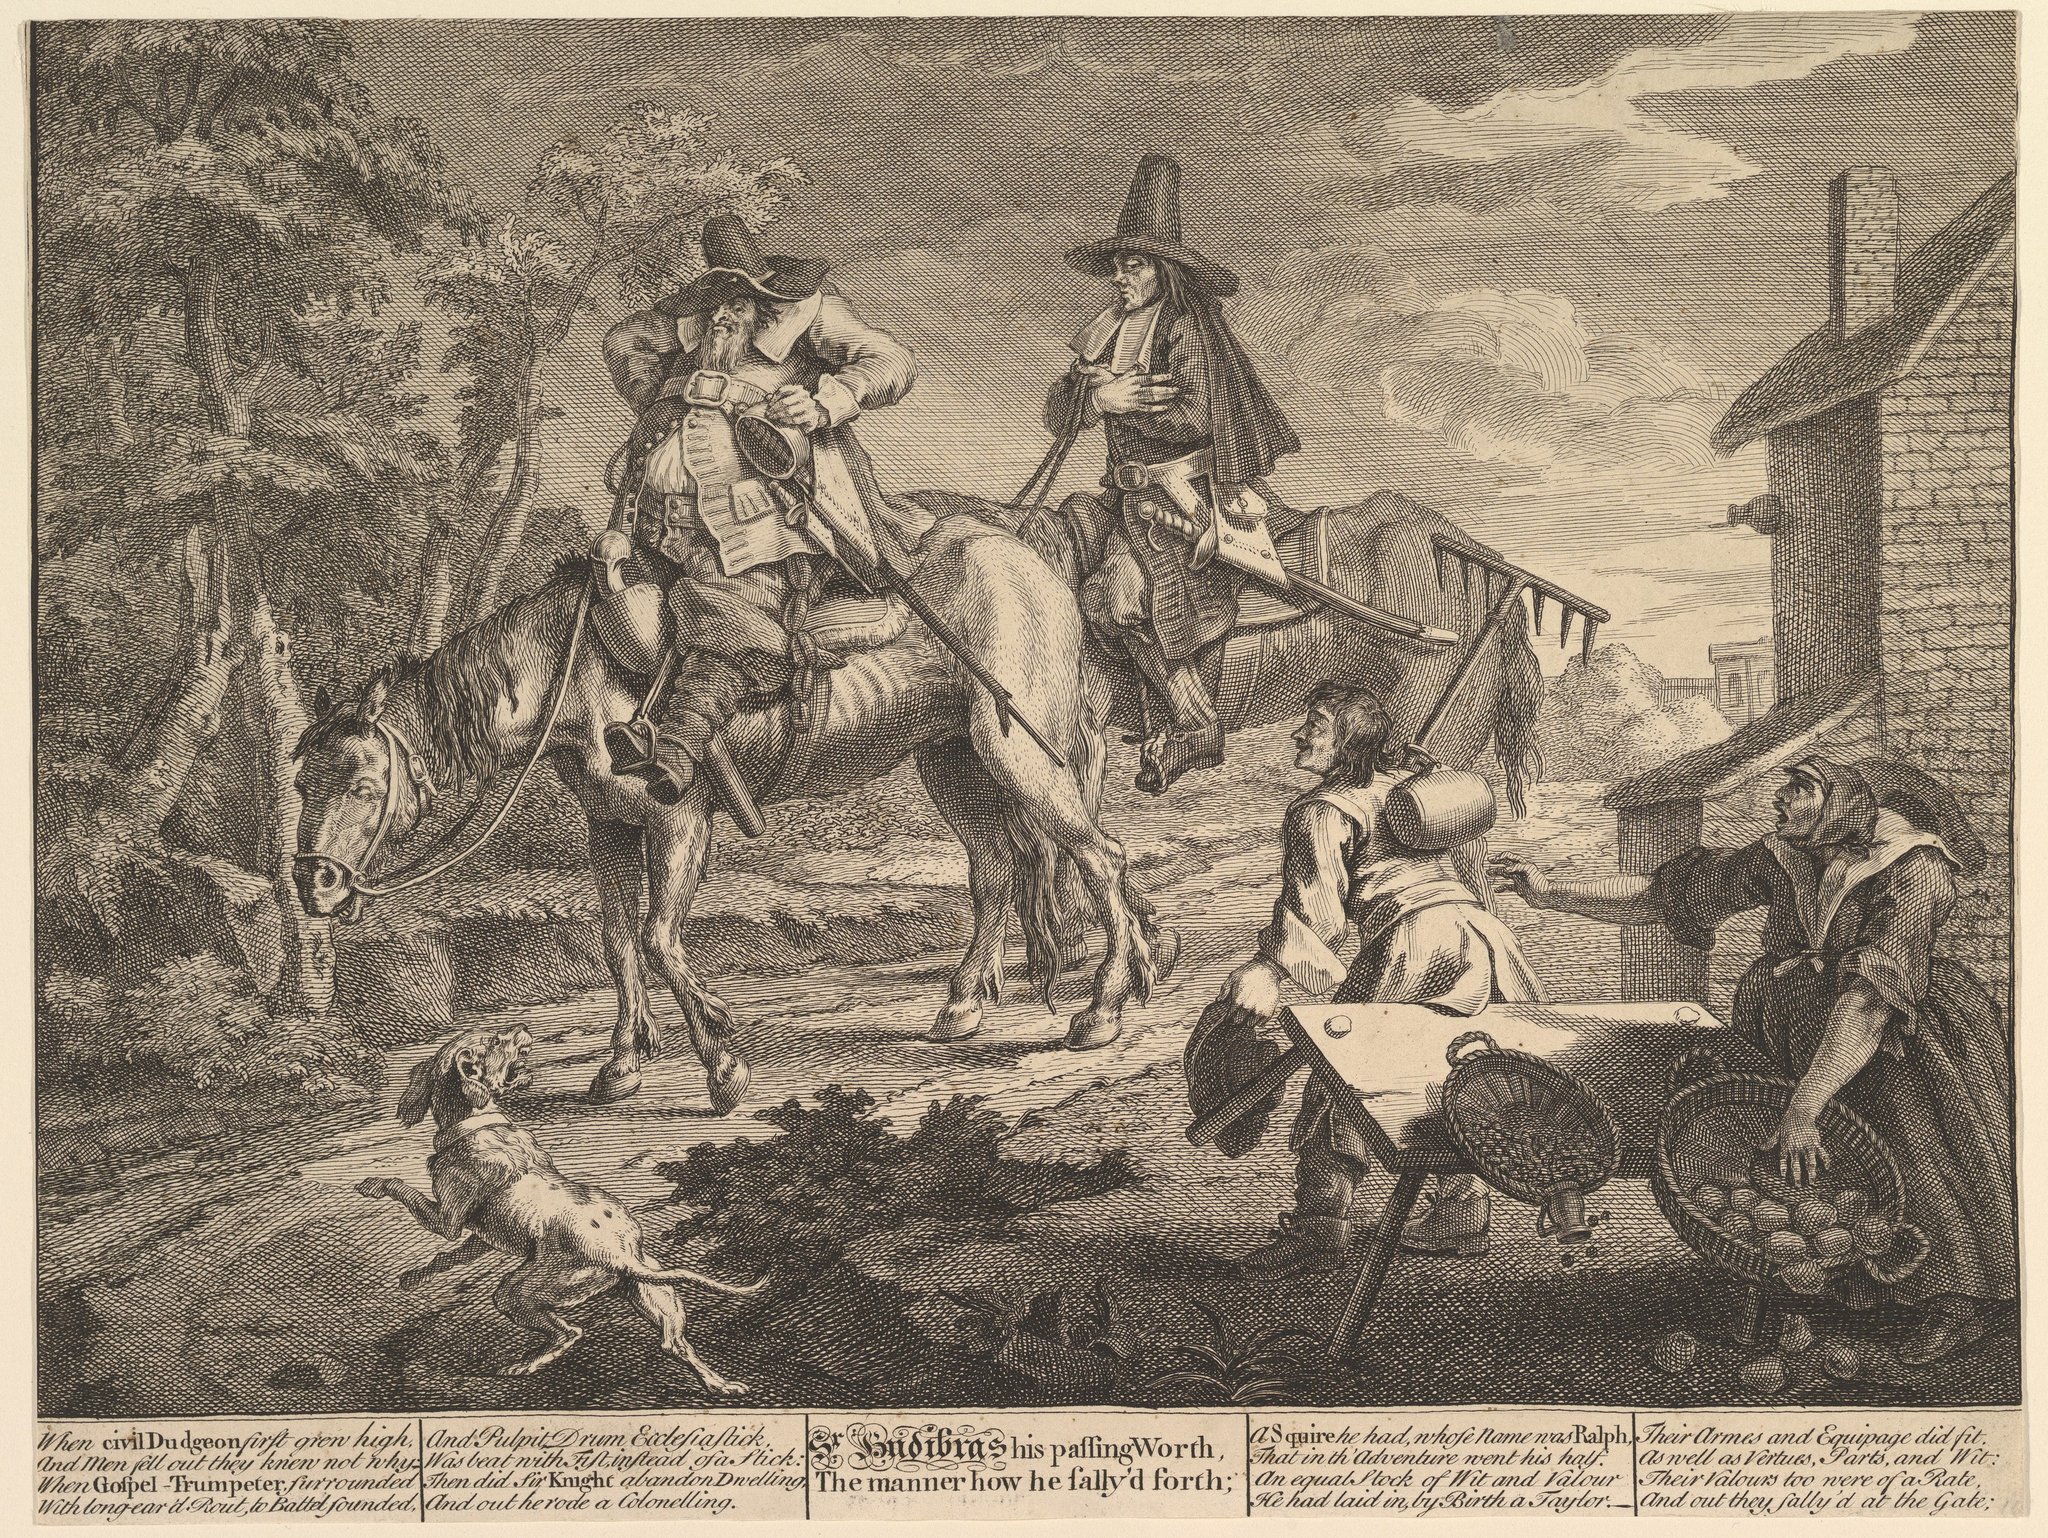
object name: print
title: Sr. Hudibras, His Passing Worth, The Manner How He Sally'd Forth": Twelve Large Illustrations for Samuel Butler's Hudibras, Plate 2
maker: william hogarth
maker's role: artist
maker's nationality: british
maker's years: 1697-1764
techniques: engraving, etching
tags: satire,men,women,dogs,horses